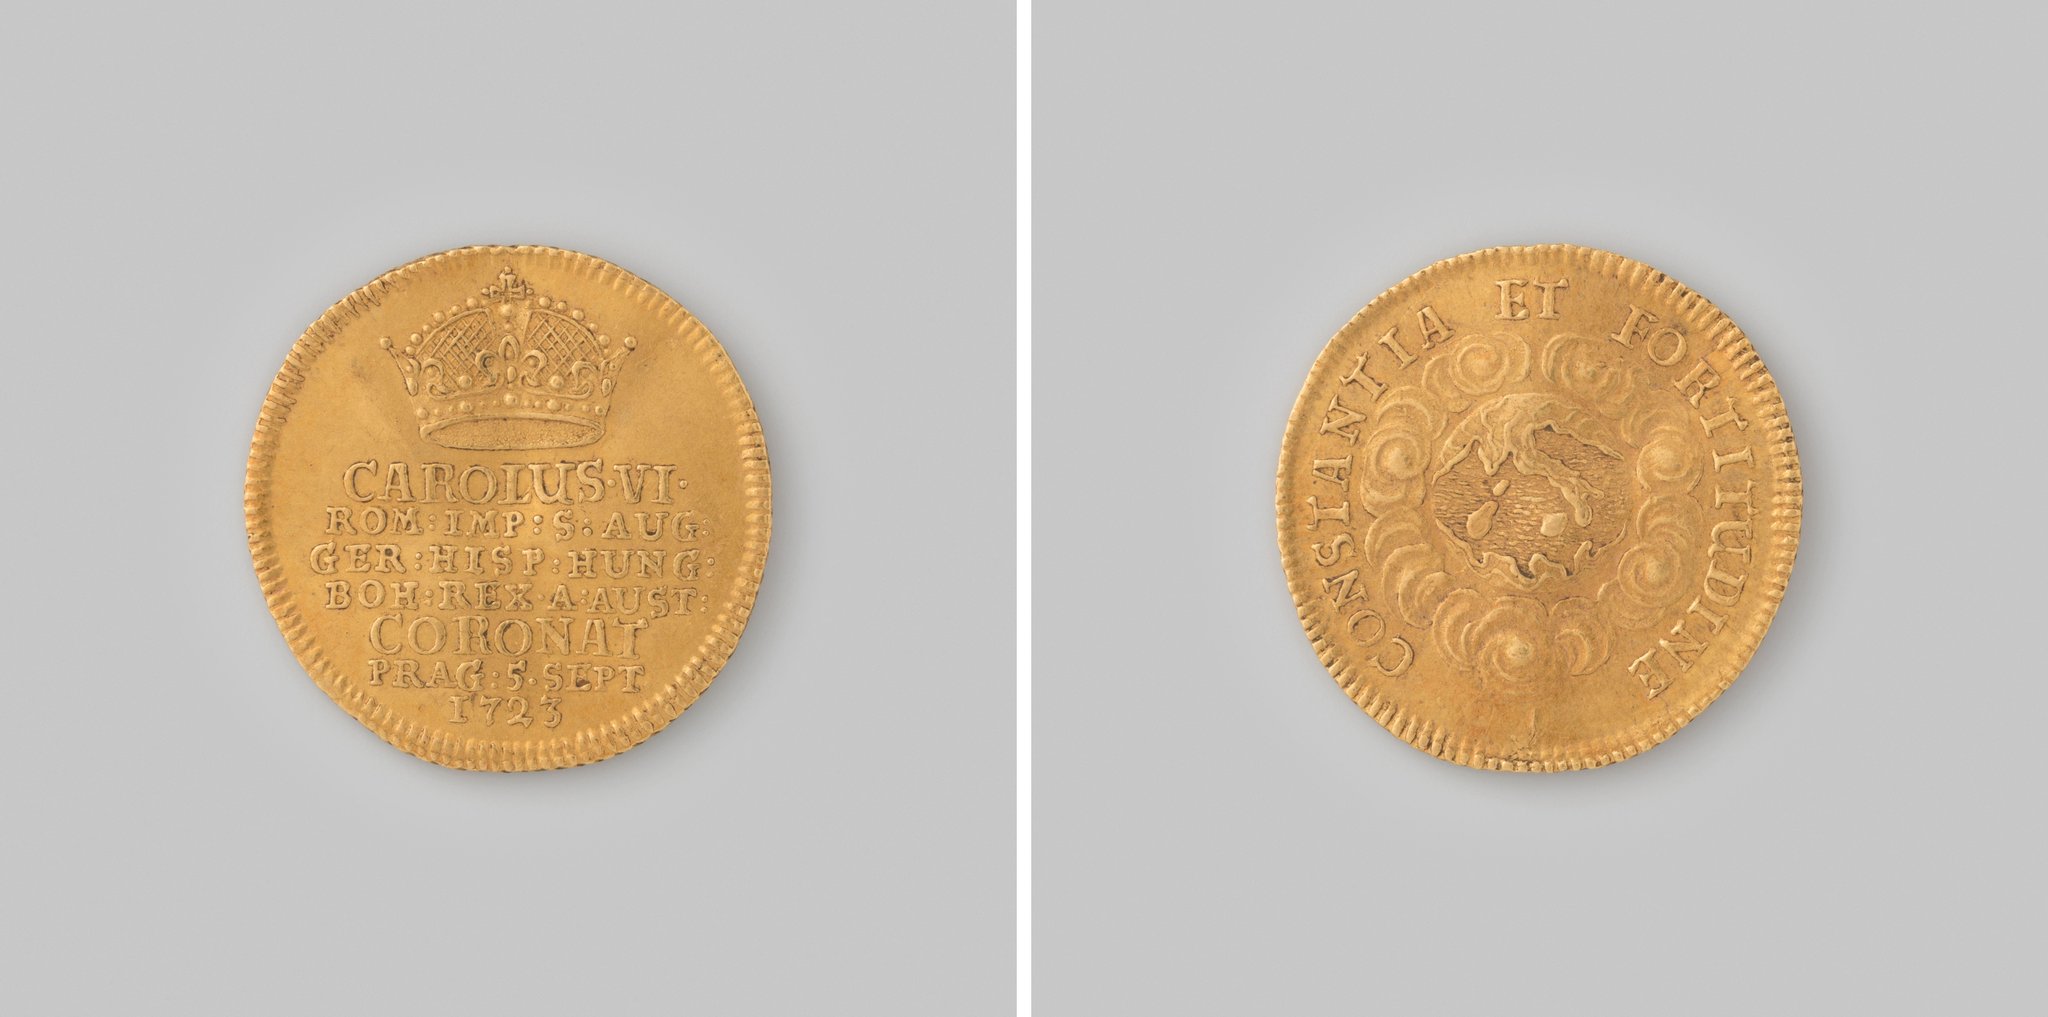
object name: ducat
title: Aartshertogdom Oostenrijk, dukaat, keizer Karel VI, 1723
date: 1723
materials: gold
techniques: striking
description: Gouden munt ter gelegenheid van kroning van Karel VI tot koning van Bohemen. Voorzijde: kroon, waaronder opschrift in zes regels. Daaronder jaartal. Keerzijde aardbol, waarop Midellandse Zee en landen rondom. Kabelrand.